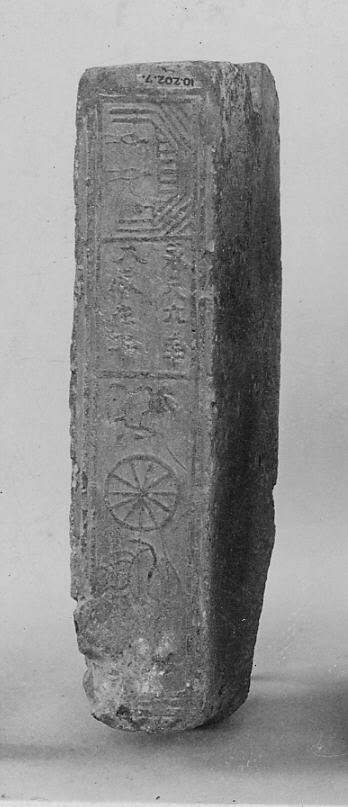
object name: tile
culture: chinese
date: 221 BCE-220 CE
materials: earthenware